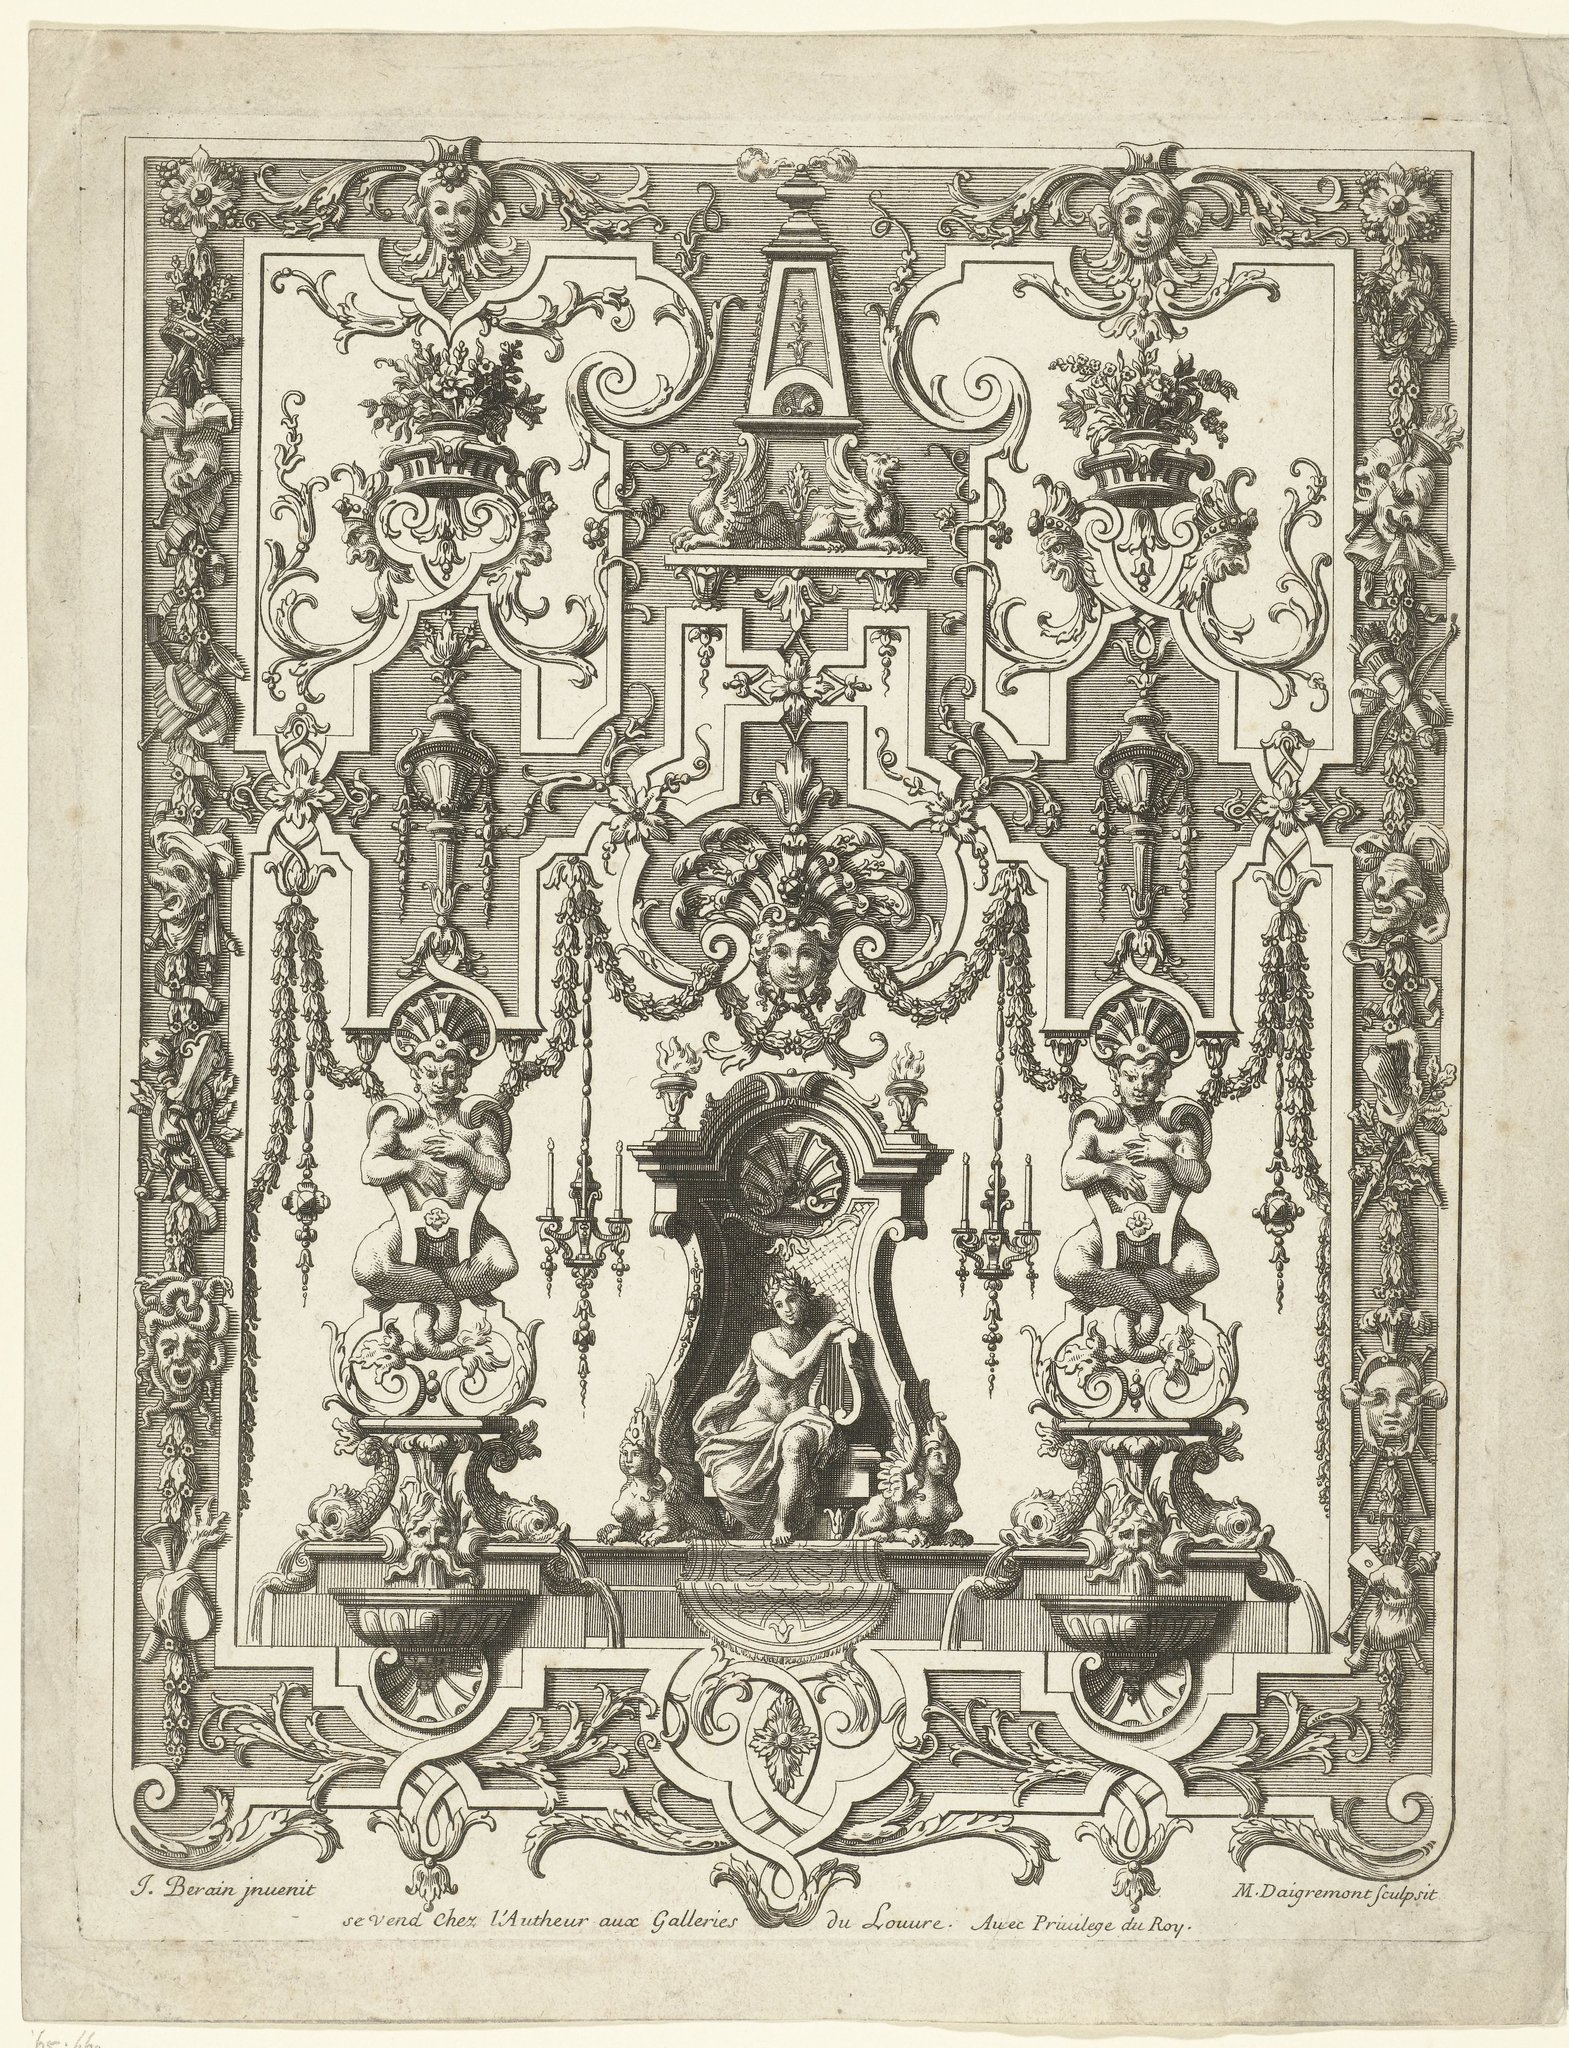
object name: print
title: Apollo on a Throne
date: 1679-1703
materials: paper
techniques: etching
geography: paris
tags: (story of) apollo (phoebus)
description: Apollo wordt geflankeerd door twee tritons gevangen in rolwerk. Blad uit serie van 6.